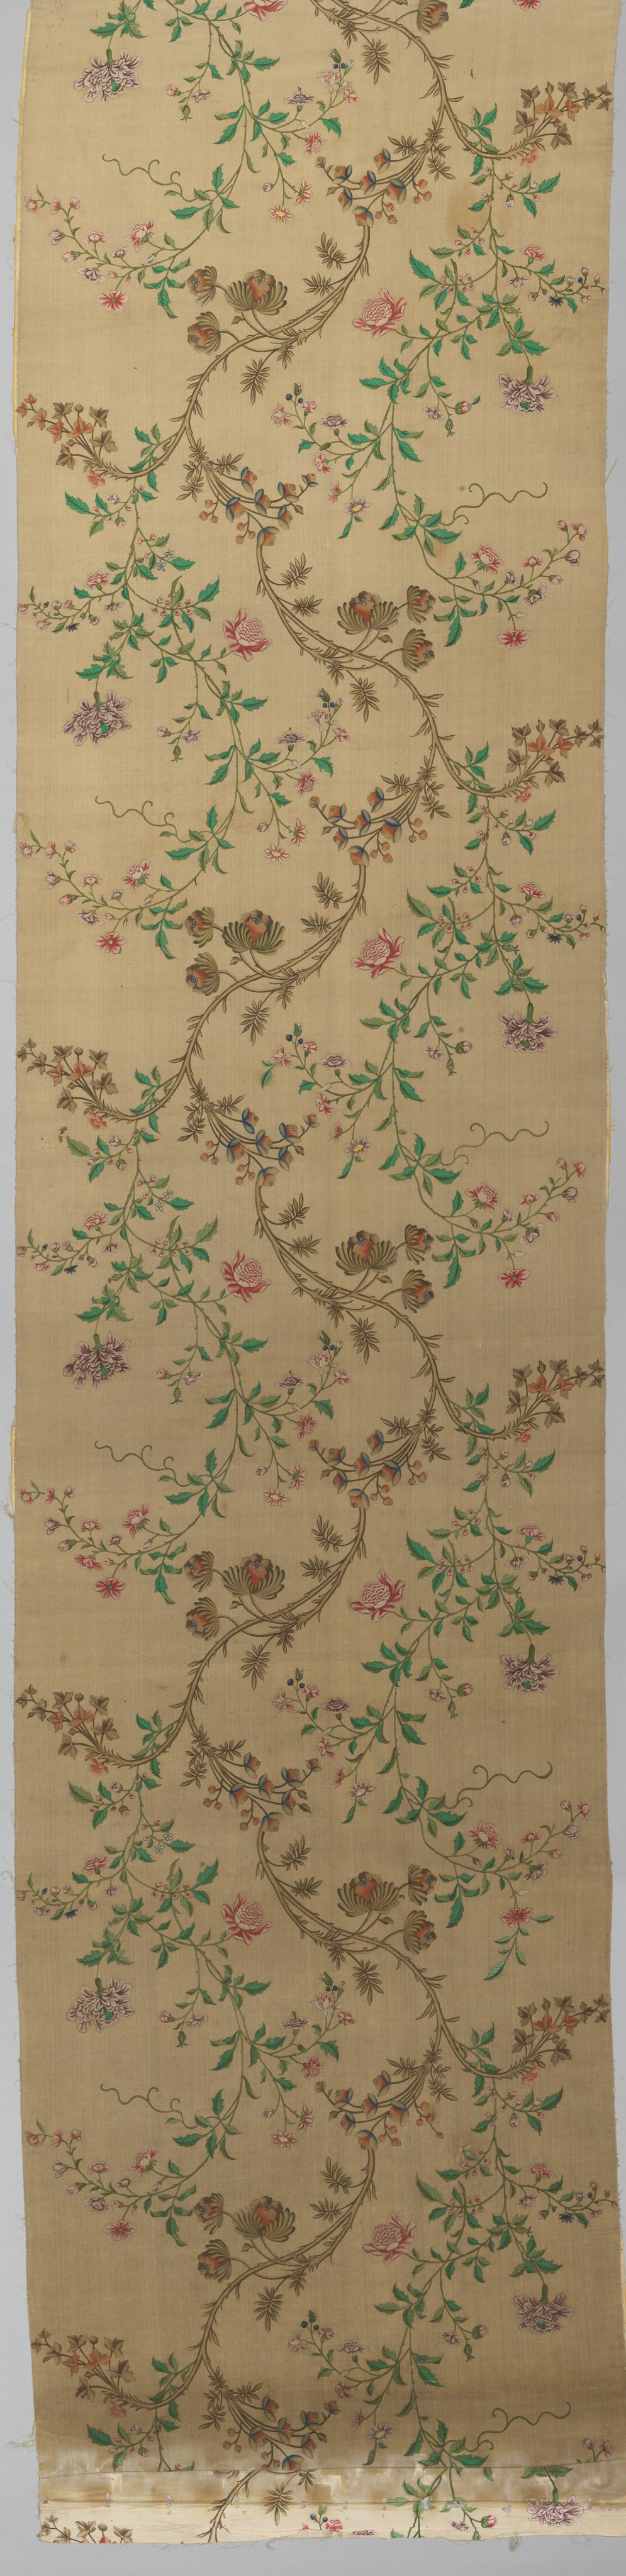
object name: interieuronderdeel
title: Bespanningsstof met decor van takken, bladeren, bloemen en vruchten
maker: Anonymous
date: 1750-1790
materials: paint, silk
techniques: printing, weave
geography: china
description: Een baan veelkleurig beschilderde creme bespanningsstof van zijde. Beschrijving zie A.